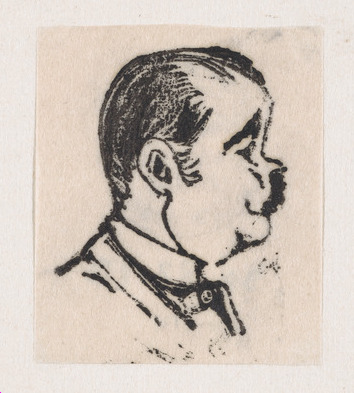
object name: print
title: A profile of a man with a dark mustache looking to the right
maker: josé guadalupe posada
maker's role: artist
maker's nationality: mexican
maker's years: 1852-1913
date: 1880-1910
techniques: woodcut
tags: men,profiles